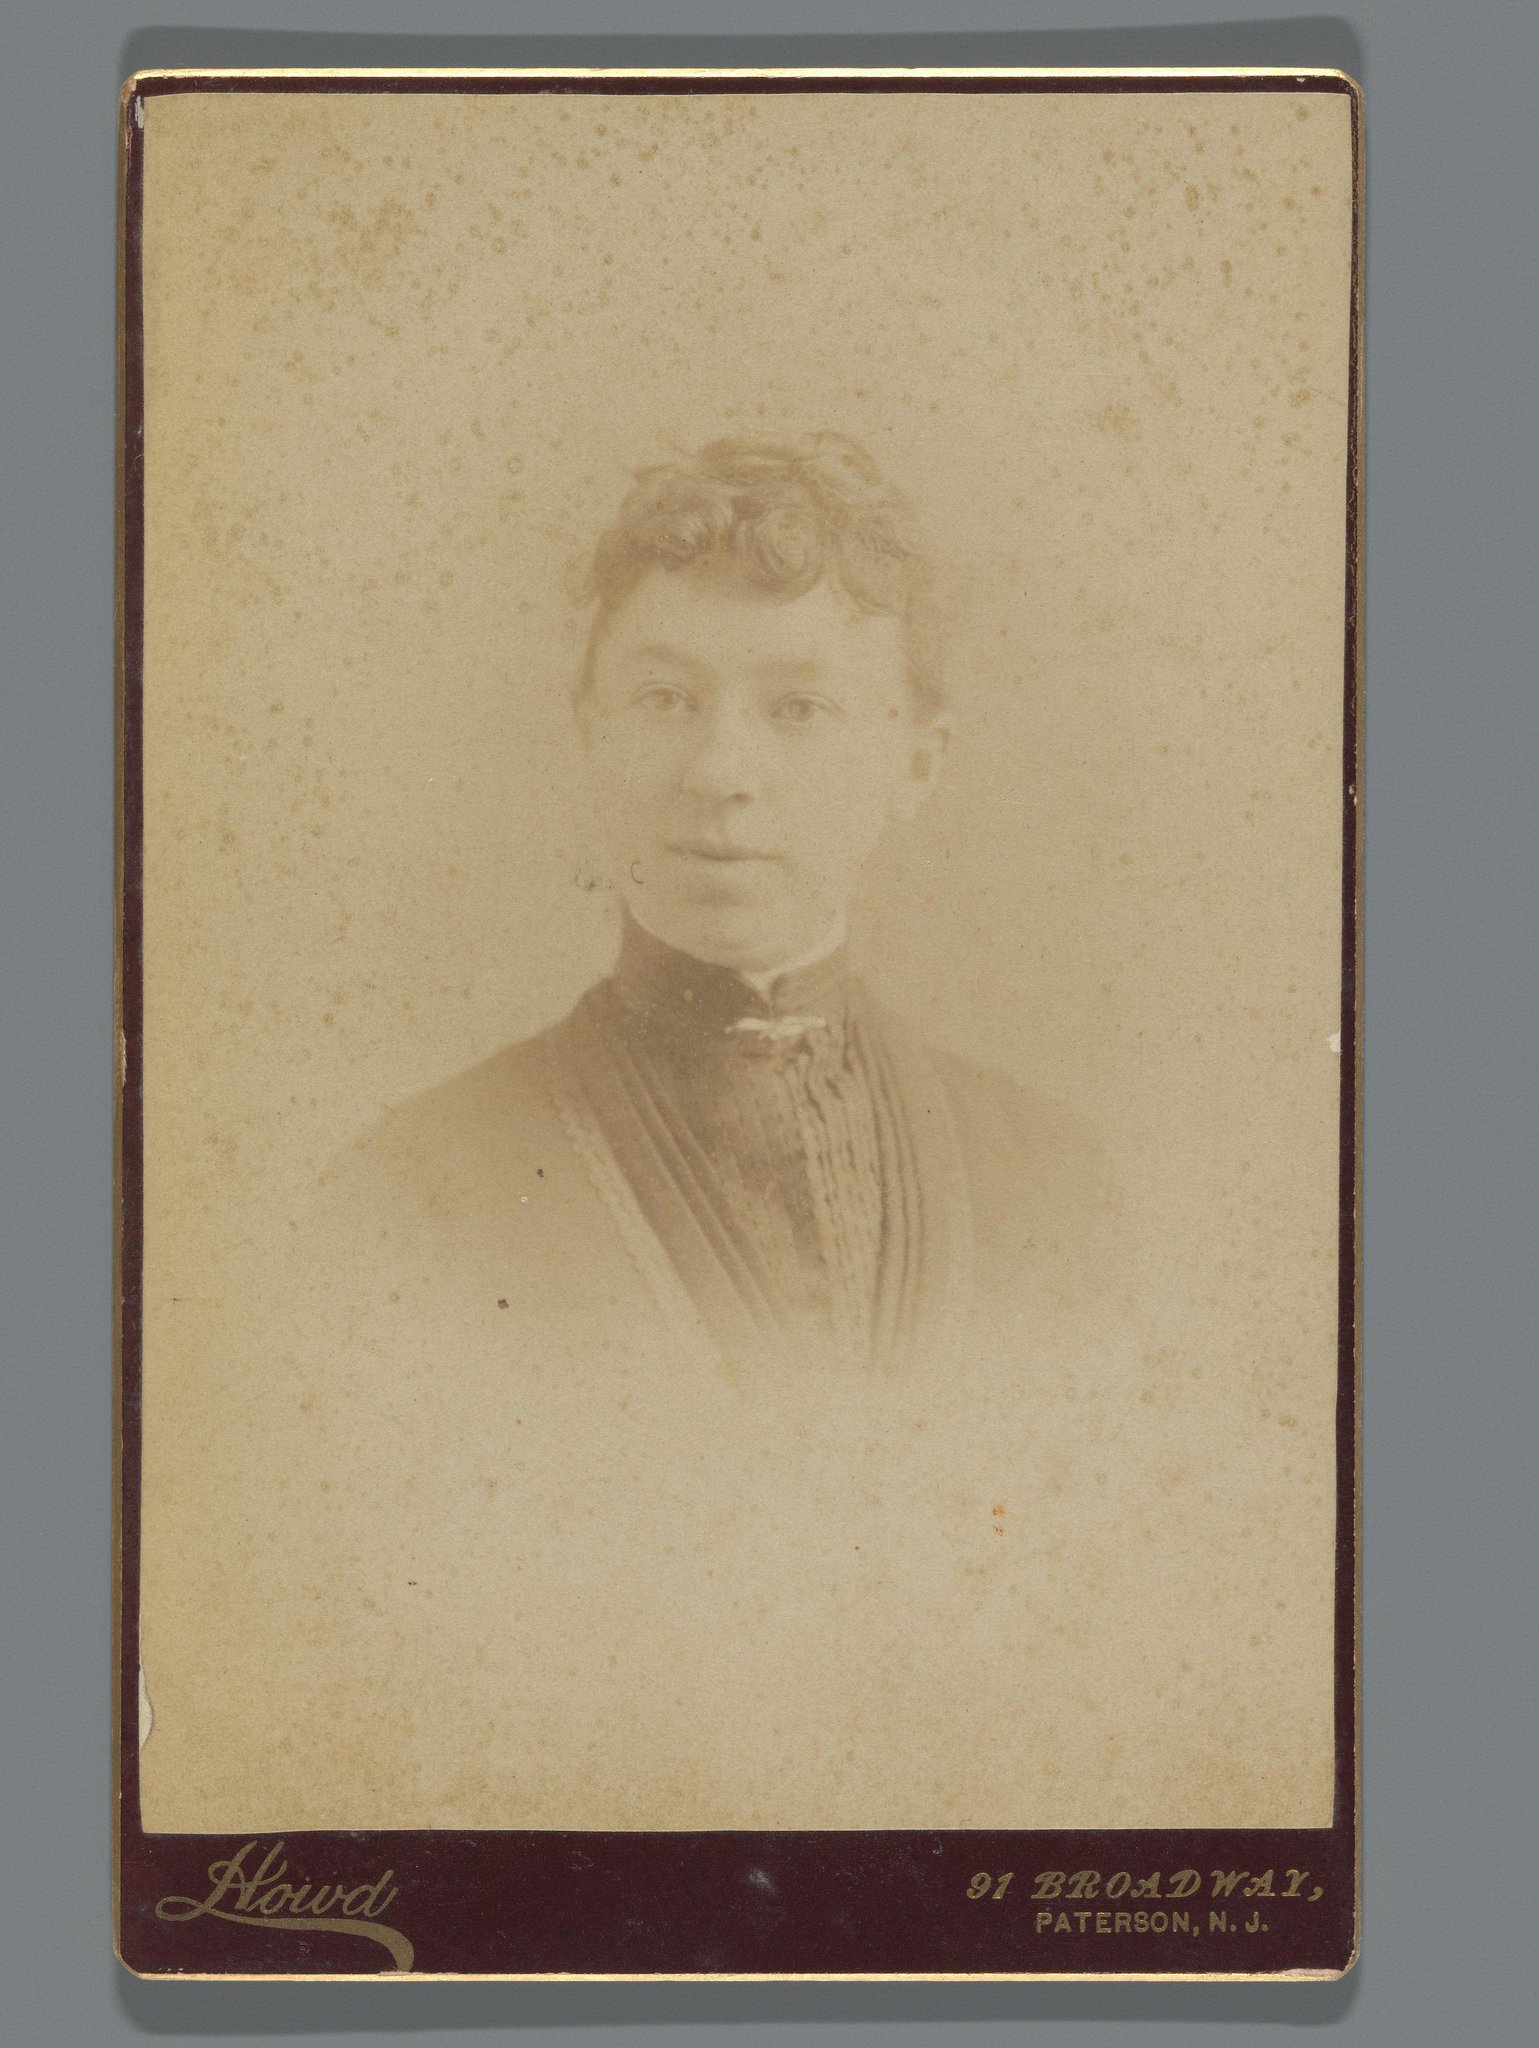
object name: cabinet photograph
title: Portret van een onbekende vrouw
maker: daniel h. howd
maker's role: fotograaf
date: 1883-1896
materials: cardboard, paper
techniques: albumen print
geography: paterson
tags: anonymous historical person portrayed - bb - woman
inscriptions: address: ‘91 BROADWAY,/ PATERSON, N.J.’